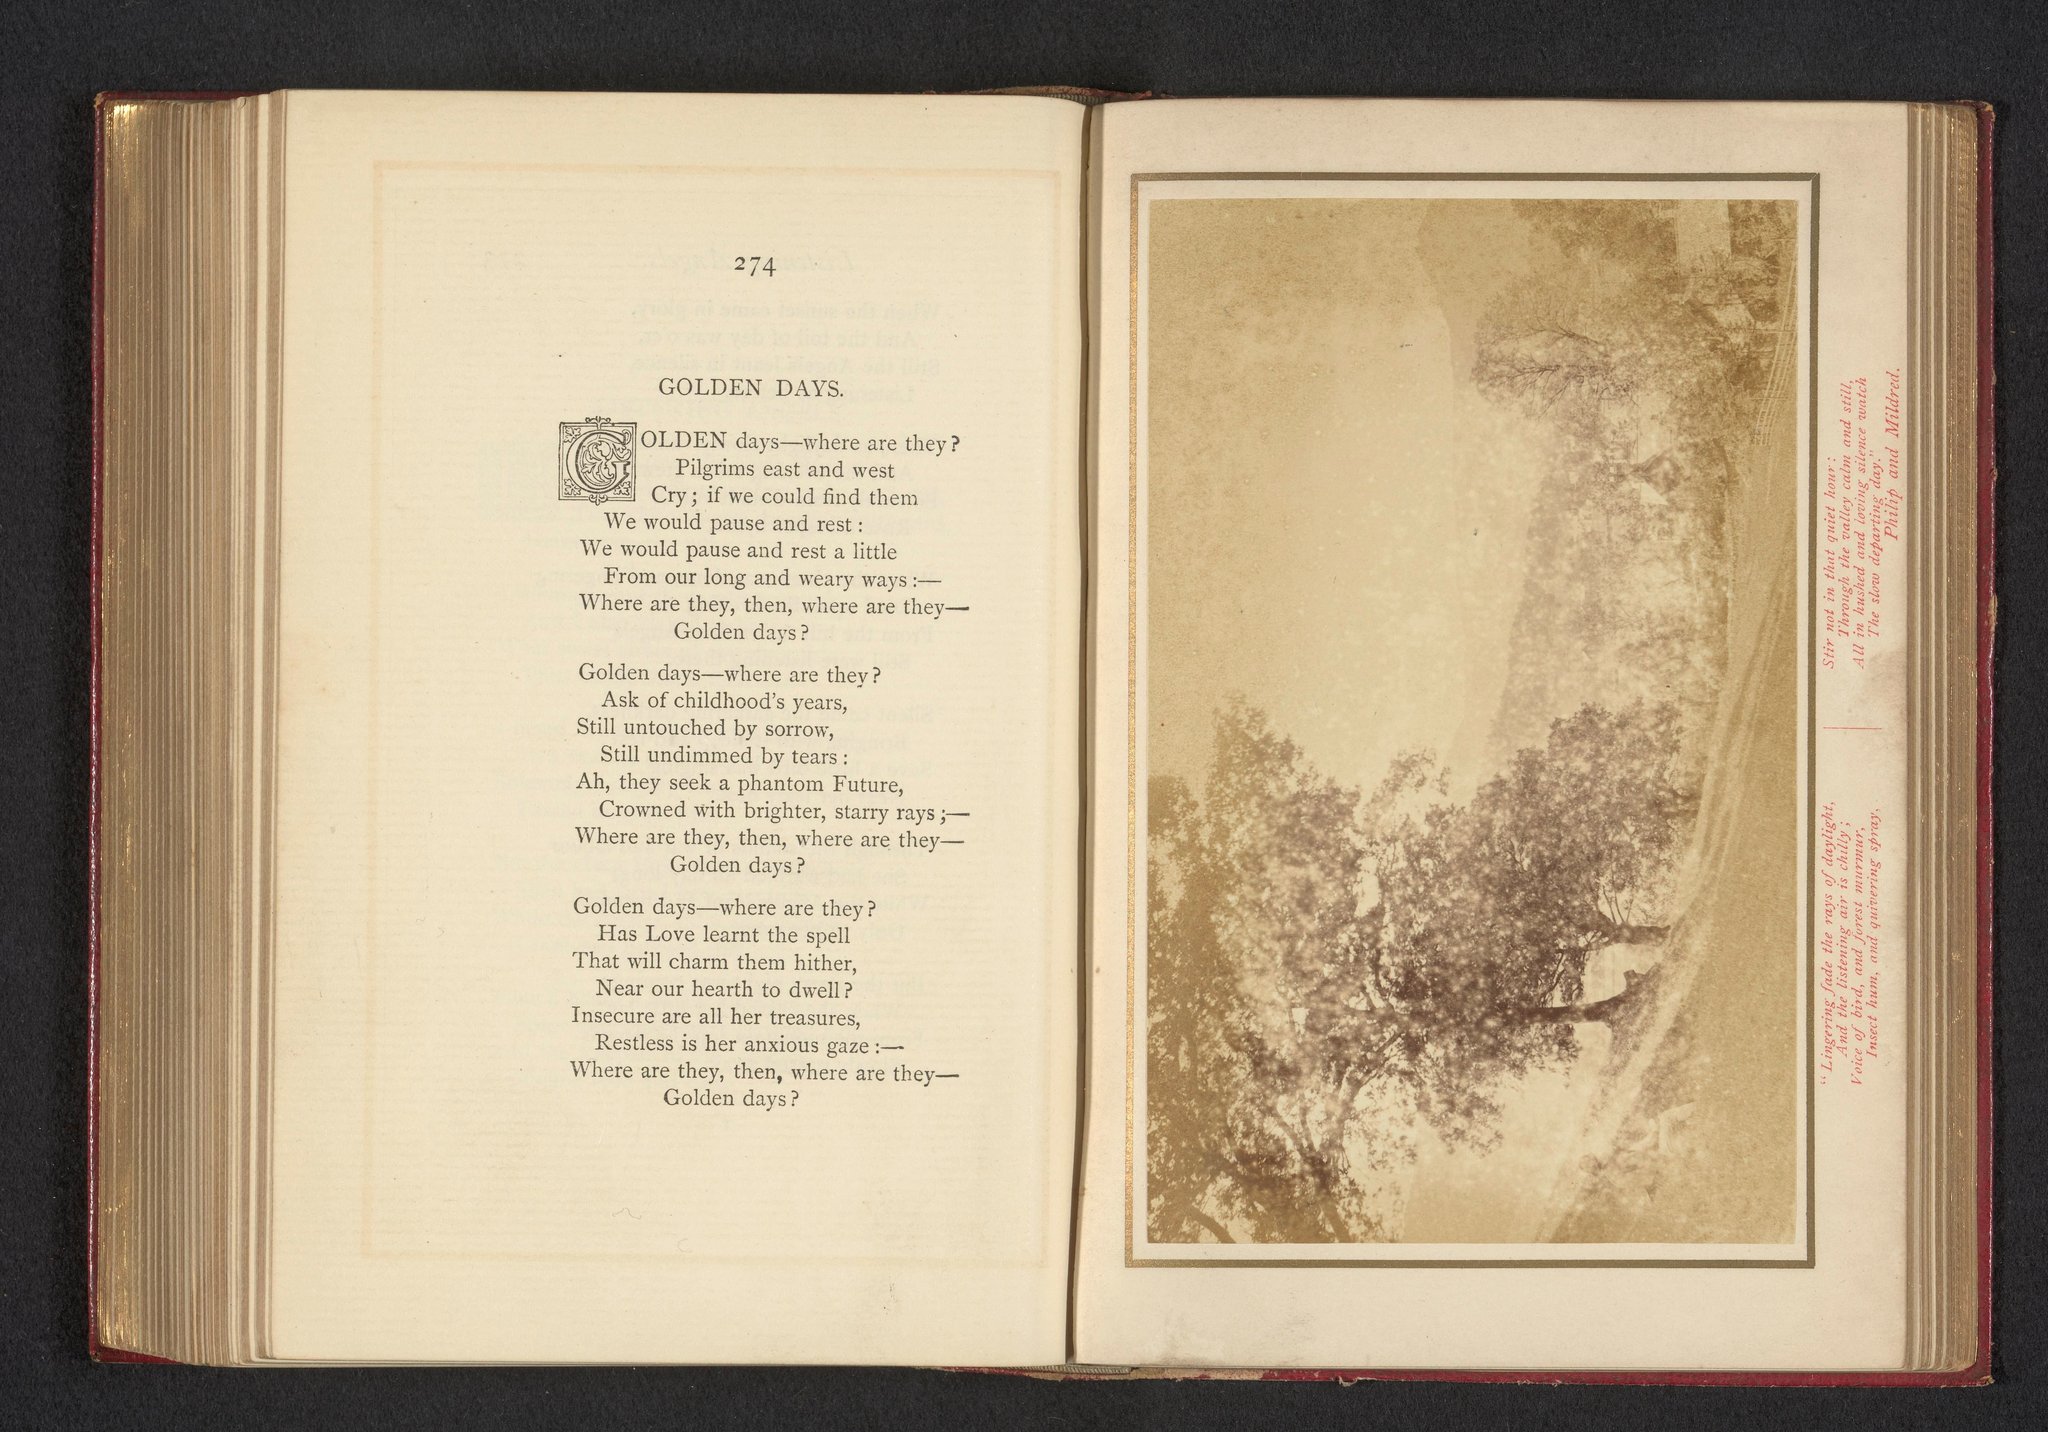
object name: photograph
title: Gezicht op een vallei met bomen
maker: john payne jennings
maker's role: fotograaf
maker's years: 1843-1926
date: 1872-1882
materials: photographic support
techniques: albumen print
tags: dale, valley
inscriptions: inscription: ‘“ Lingering fade the rays of daylight, And the listening air is chilly (...) Philip and Mildred..’